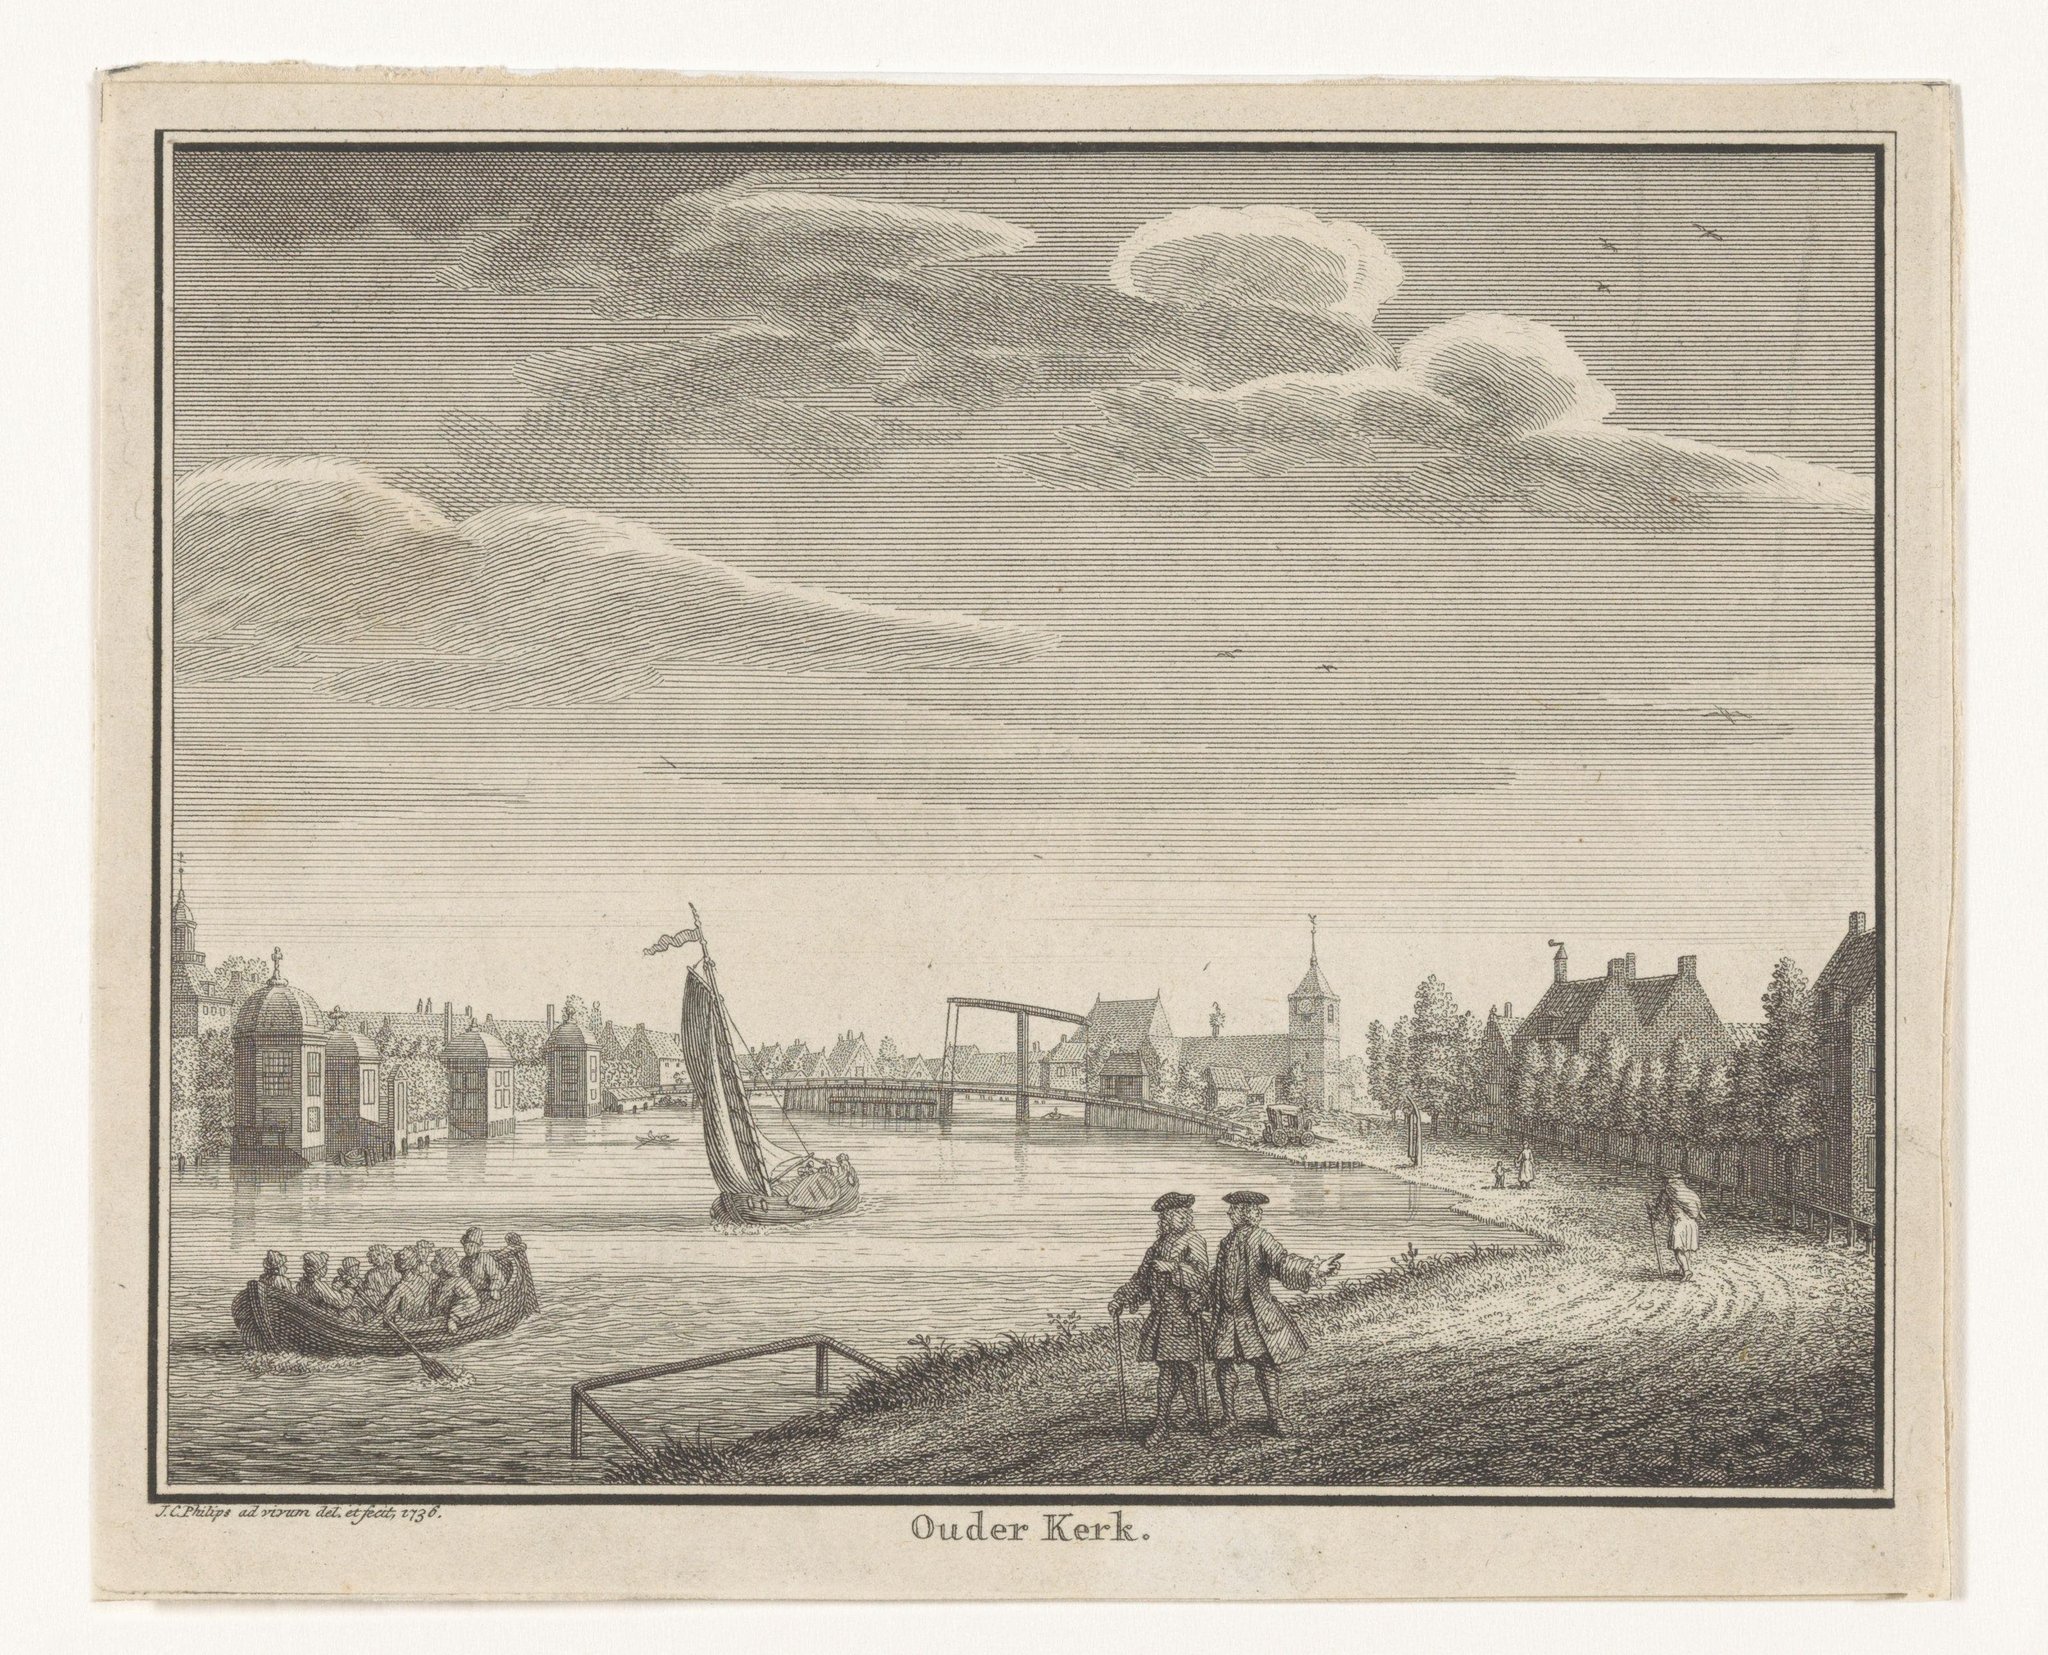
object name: book illustration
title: Ouder Kerk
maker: jan caspar philips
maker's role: draughtsman, print maker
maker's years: 1700-1775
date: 1736-1773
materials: paper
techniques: etching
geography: amsterdam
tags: prospect of village, silhouette of village, river, church (exterior), public road in village, bridge in village across river, canal, etc.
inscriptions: collector's mark: Lugt 2233, collector's mark: Lugt 195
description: Prent ook gebruikt in: Schoemaker, Gerrit ed. Daniel Willinks Amstellandsche Arkadia, of beschryving van de gelegenheit, toestant en gebeurtenissen van Amstellandt, met deszelfs onderhoorige dorpen, heerlykheden, ambachten, lusthoven, wateren, enz. (…). 2 delen. 1e druk. Amsterdam: Arend van Huyssteen, 1737, dl. 1, p. 130. Of in: Schoemaker, Gerrit ed. Daniel Willinks Amstellandsche Arkadia, of beschryving van de gelegenheit, toestant en gebeurtenissen van Amstellandt, met deszelfs onderhoorige dorpen, heerlykheden, ambachten, lusthoven, wateren, enz. (…). 2 delen. 2e druk. Utrecht: Samuel de Waal, 1773, dl. 1, p. 125.